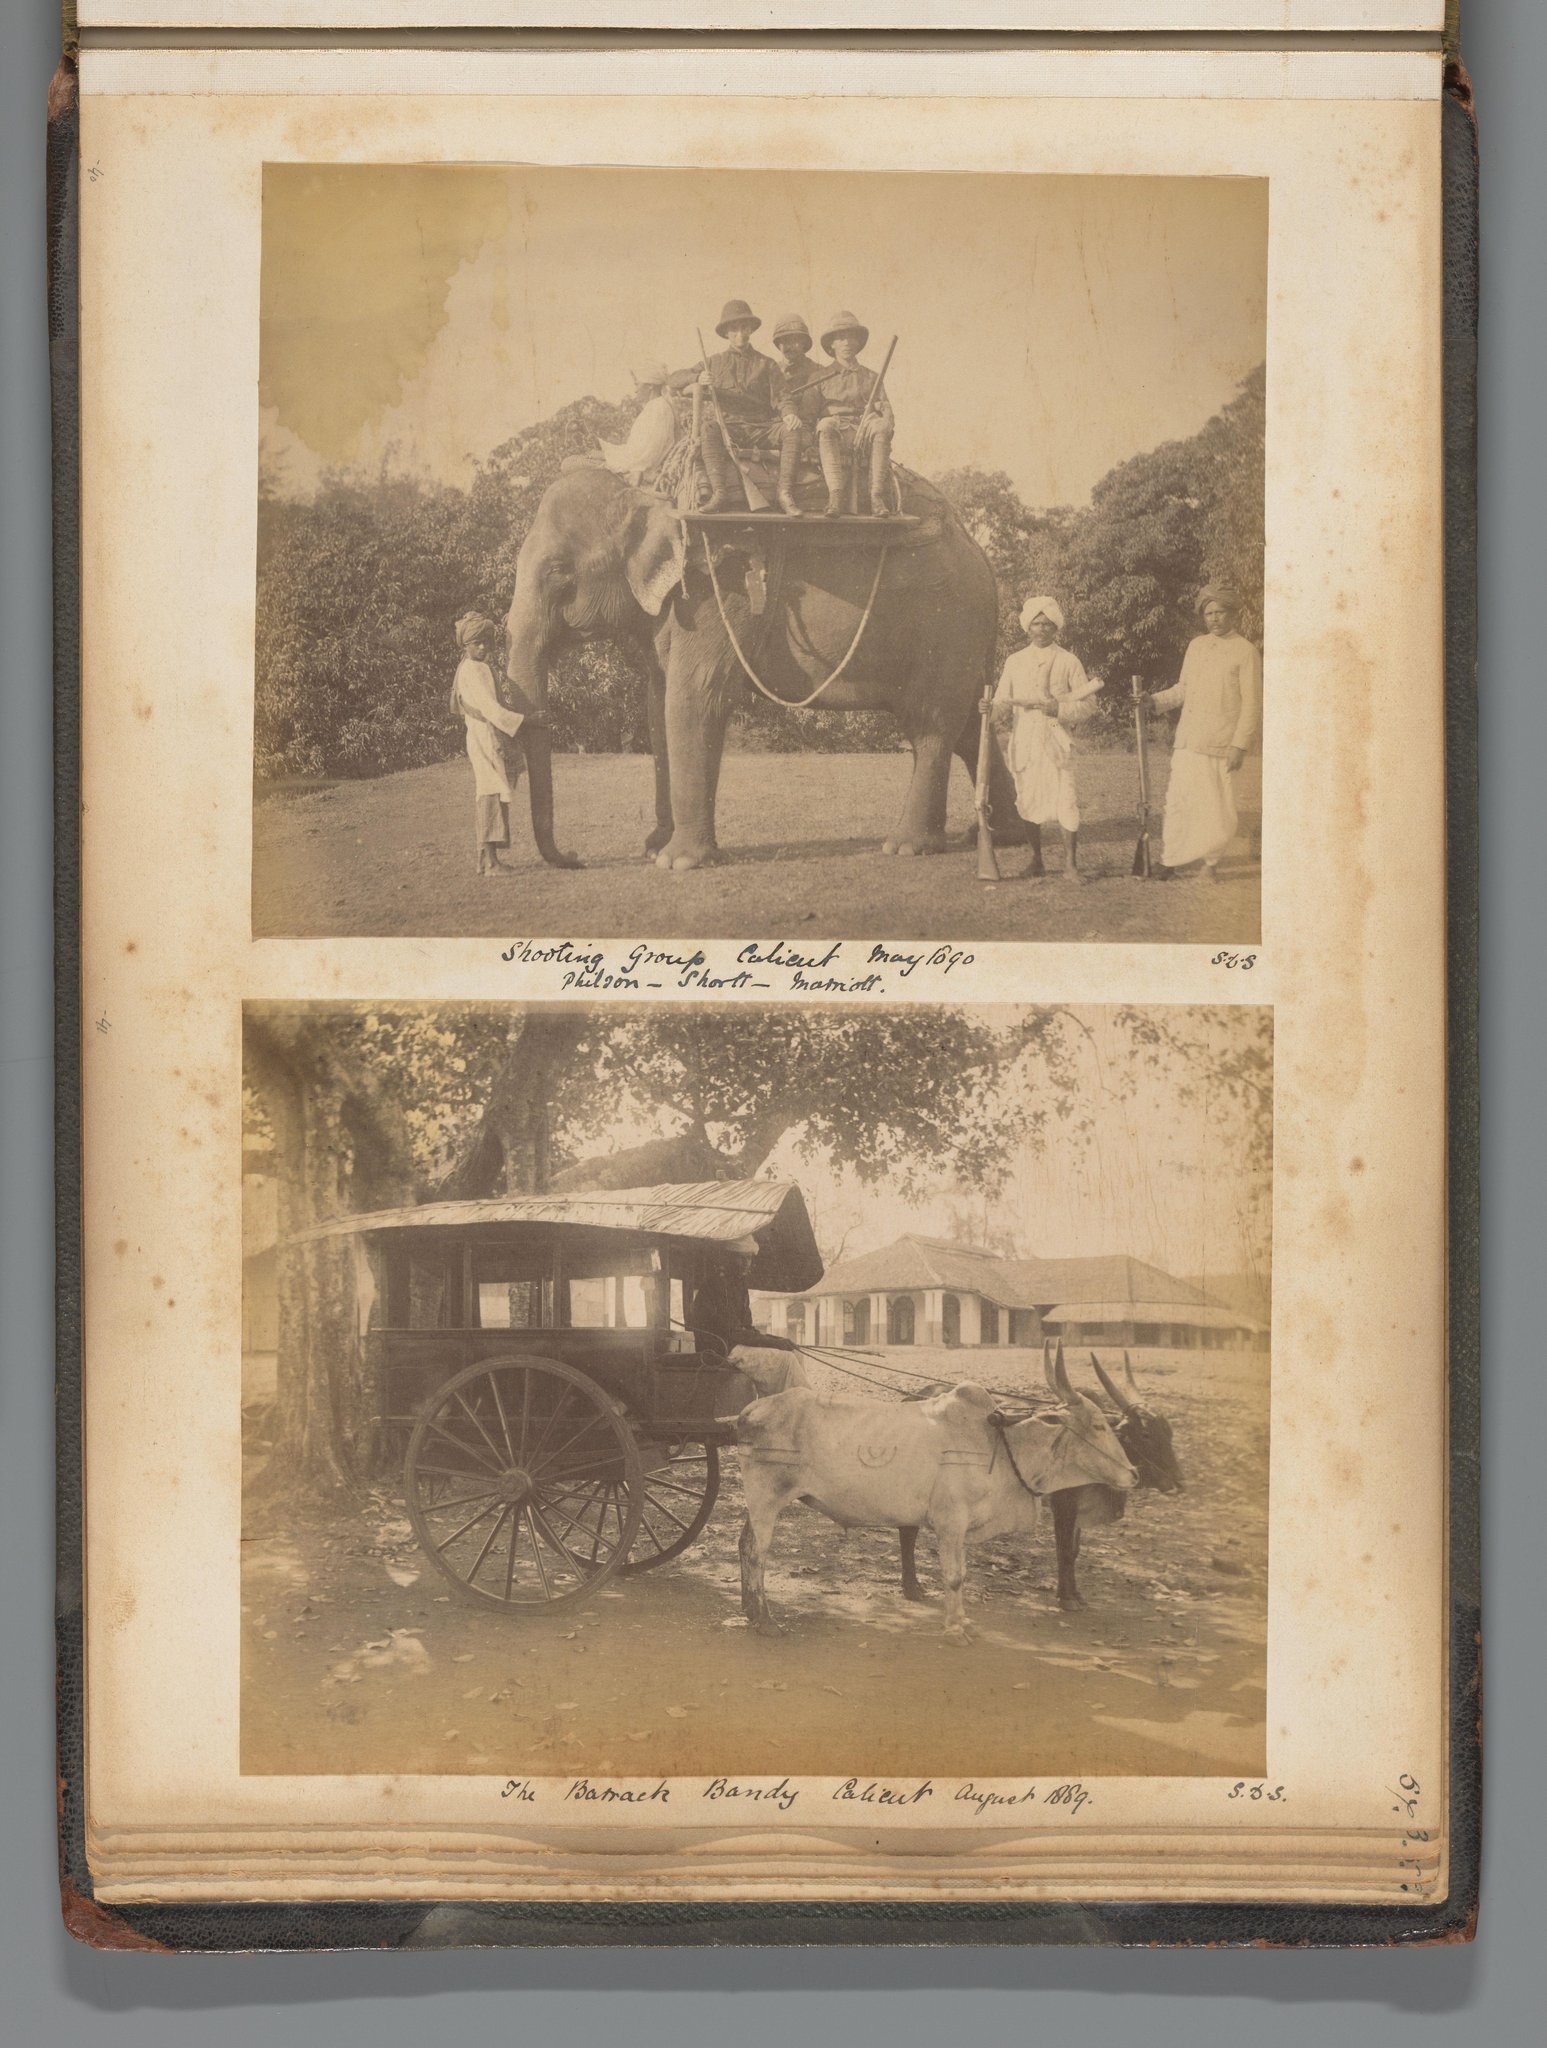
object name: photograph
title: Drie Britse militairen op een olifant, bijgestaand door vier bedienden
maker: c.c. blackburn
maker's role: fotograaf, luitenant-kolonel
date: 1805-1890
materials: paper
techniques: albumen print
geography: calicut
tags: the soldier; the soldier's life, trunked animals: elephant